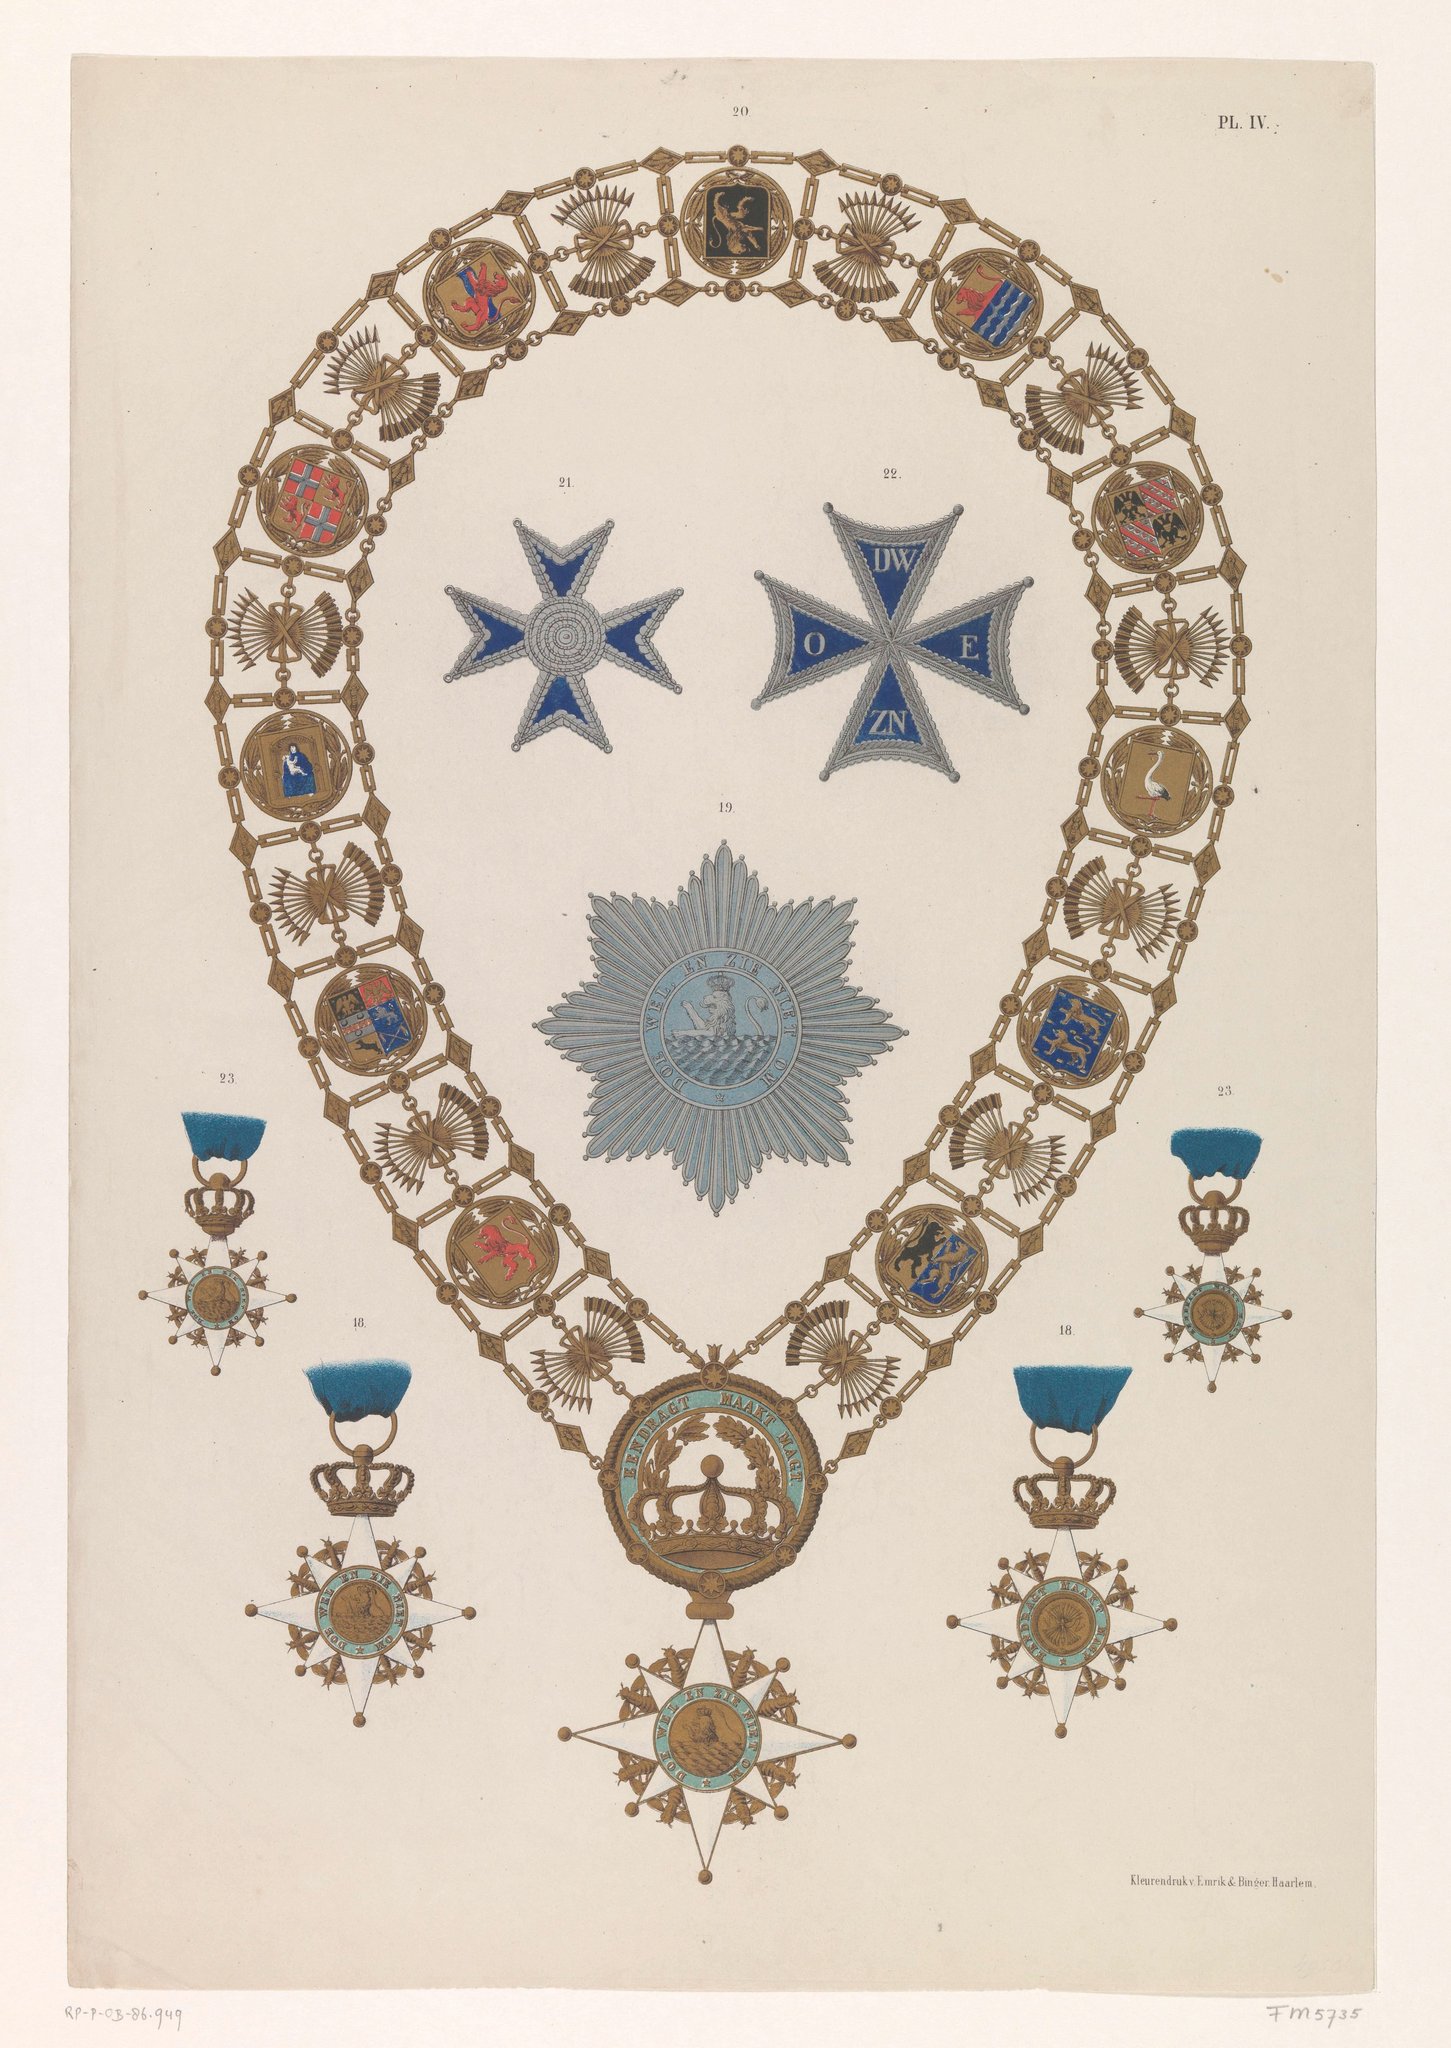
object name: print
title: Ordeketen met het grootkruis van de Koninklijke Orde van Holland, 1807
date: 1856-1858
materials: paper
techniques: lithograph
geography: haarlem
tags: louis napoleon (king of holland), knighthood order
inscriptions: collector's mark: Lugt 2228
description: Het Grote Keten met het kruis van de Koninklijke Orde van Holland, later genoemd Orde van de Unie. Onderscheiding ingesteld door koning Lodewijk Napoleon, voor het eerst in 1806. Deze variant van het versiersel met een zwemmende of uitkomende leeuw dateert van 14 februari 1807. Op ware grootte. Centraal de geborduurde ster en twee andere geborduurde kruisvormige draagtekens, onderaan apart de voorzijde en achterzijde van het grootkruis en de voor- en keerzijde van een kleiner variant. De verschillende onderdelen genummerd (legenda ontbreekt) en genummerd: Pl. IV.